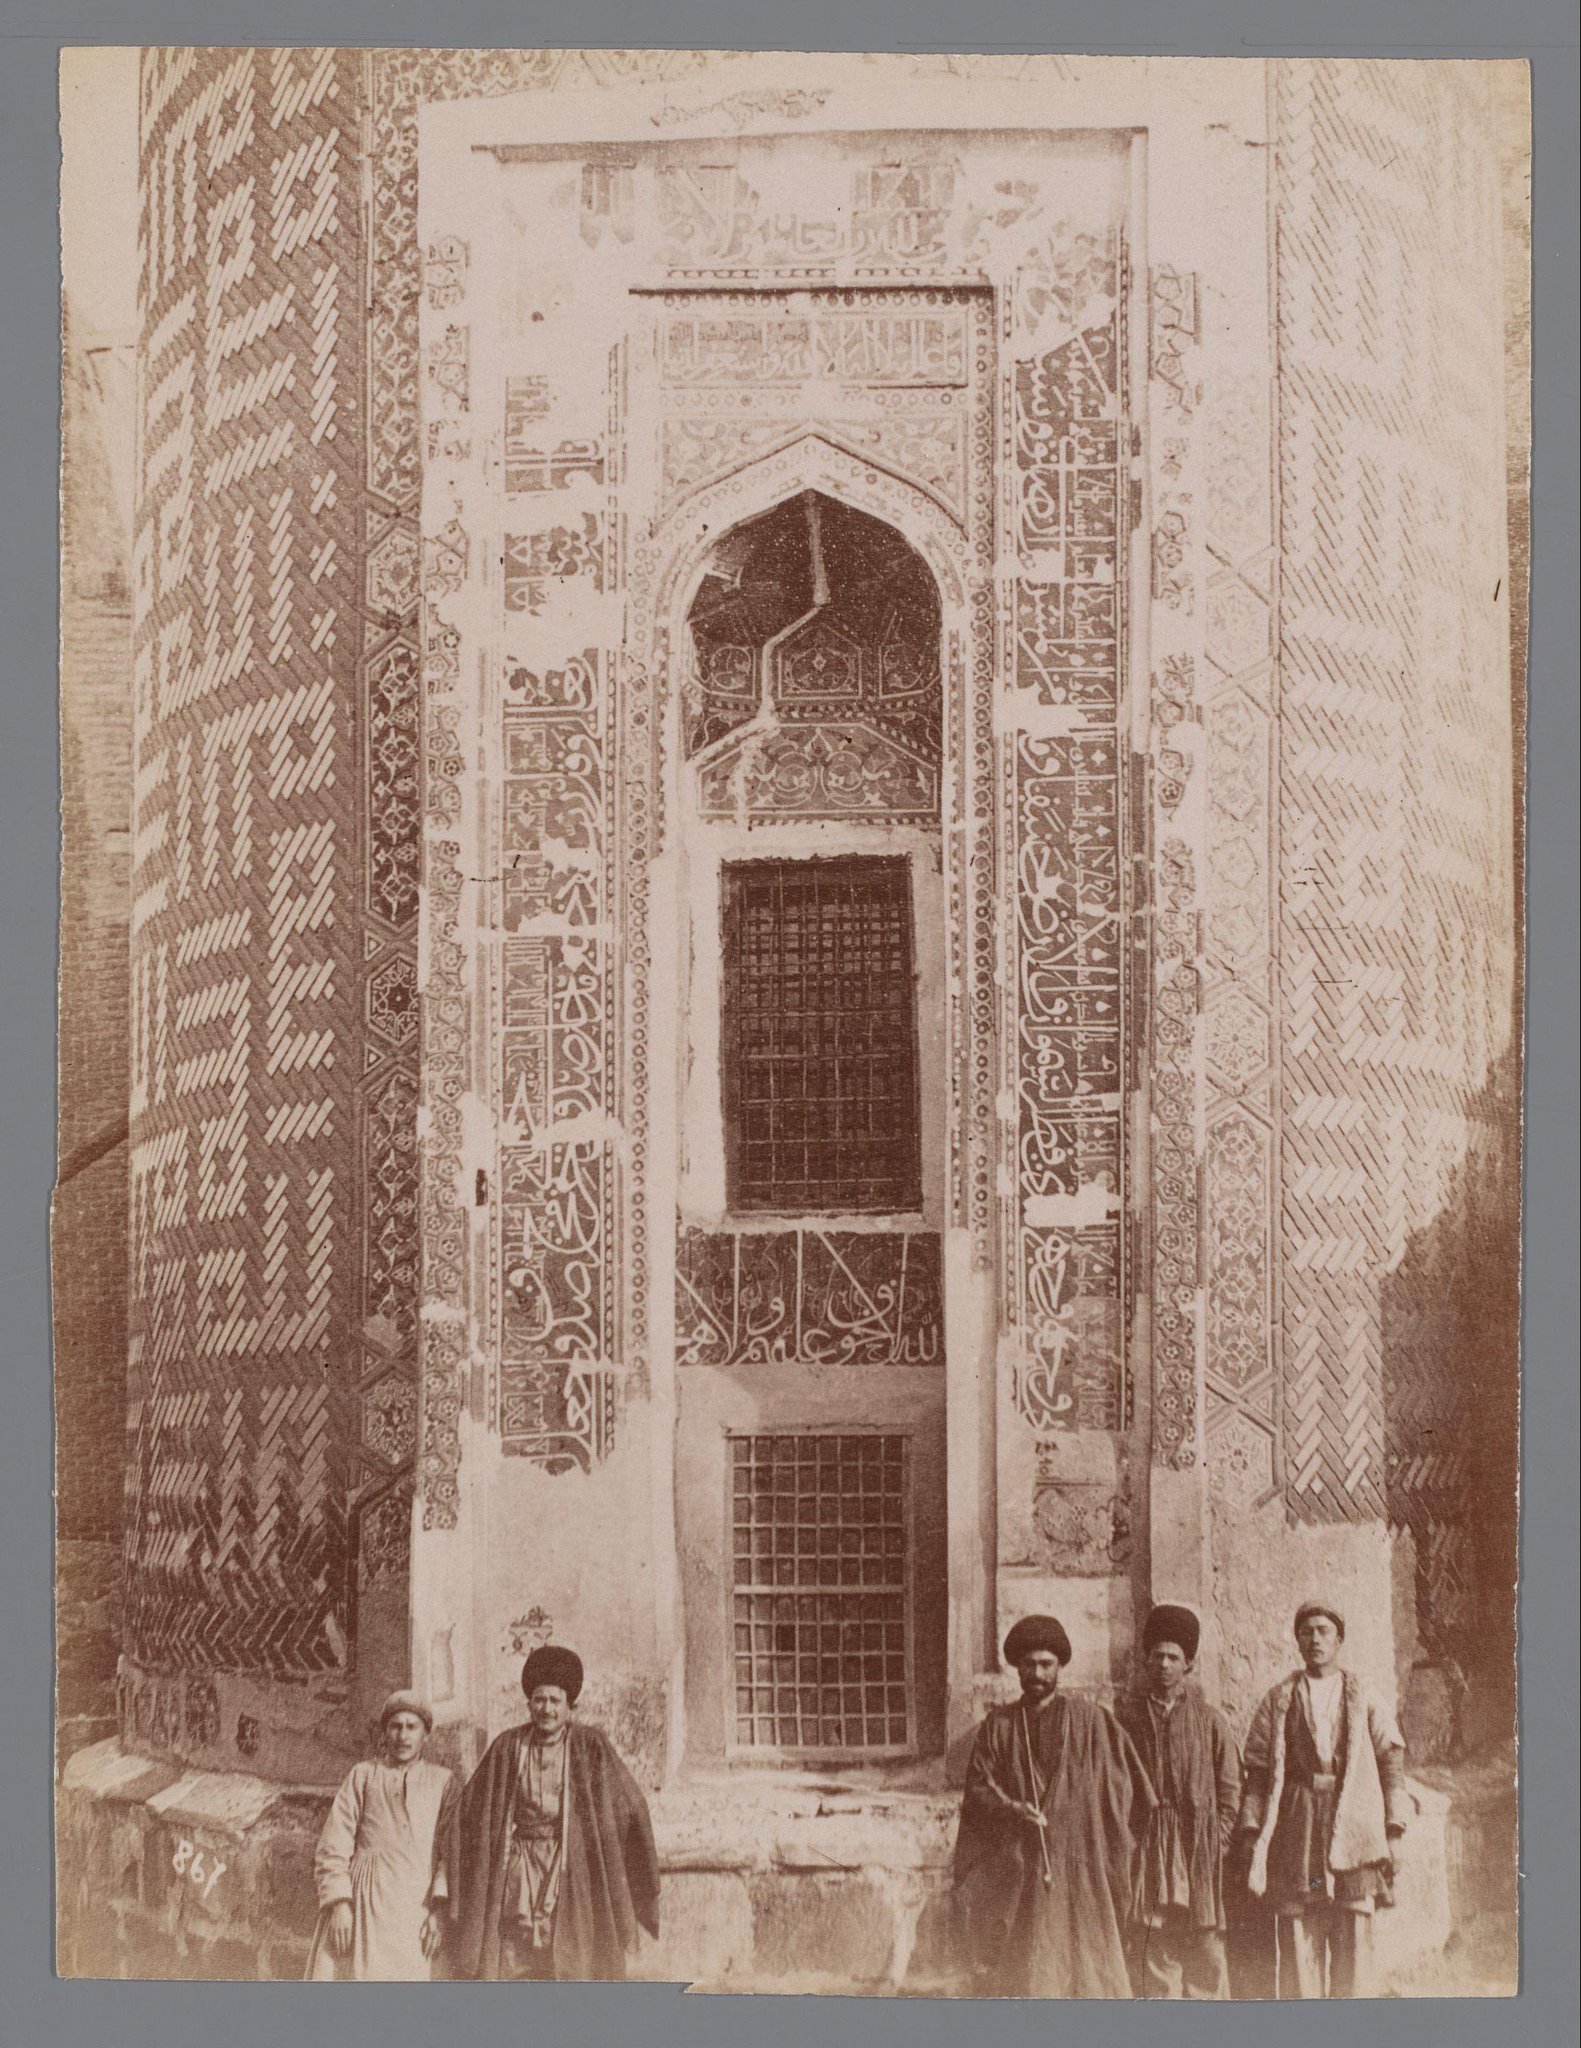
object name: photograph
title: Graf van sheik Safi ad-Din Is'haq Ardabili, Iran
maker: antoine sevruguin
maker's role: fotograaf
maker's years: 1840-1933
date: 1885-1910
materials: paper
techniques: albumen print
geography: iran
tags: iran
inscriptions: number: ‘867’, inscription: ‘Ardeliel [?] Tombeau de Champs Sofi [?]’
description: Toren van het grafmonument van Graf van sheik Safi ad-Din Is'haq Ardabili, Iran.